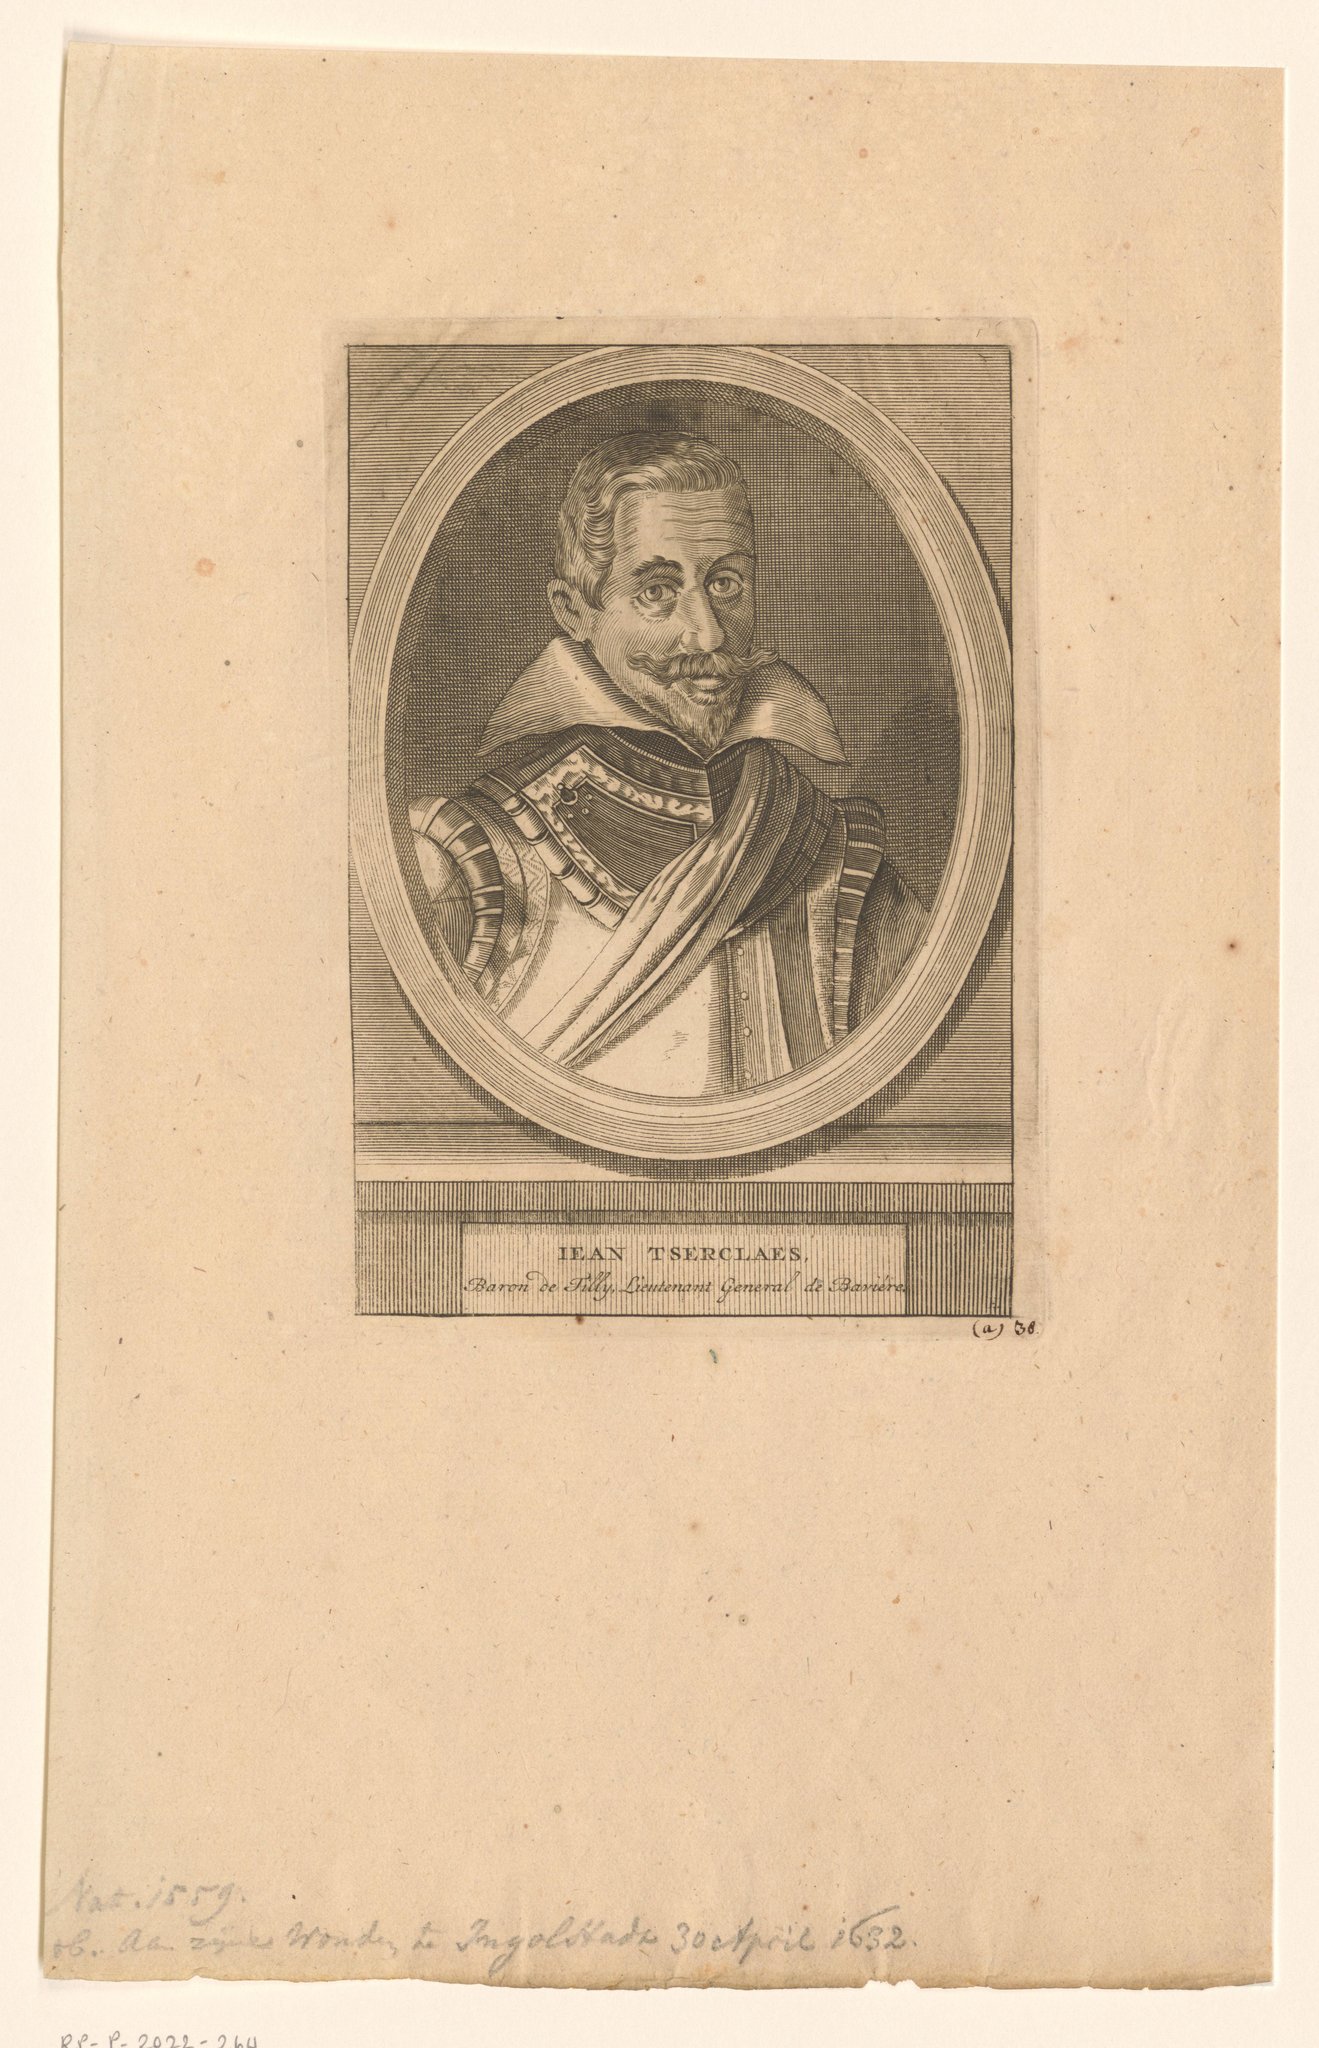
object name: print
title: 48 portretten van graven, barons, ridders en generaals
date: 1715-1730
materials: paper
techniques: engraving, etching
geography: leiden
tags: commander-in-chief, general, marshal, armour, historical persons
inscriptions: number: ‘(a)38’